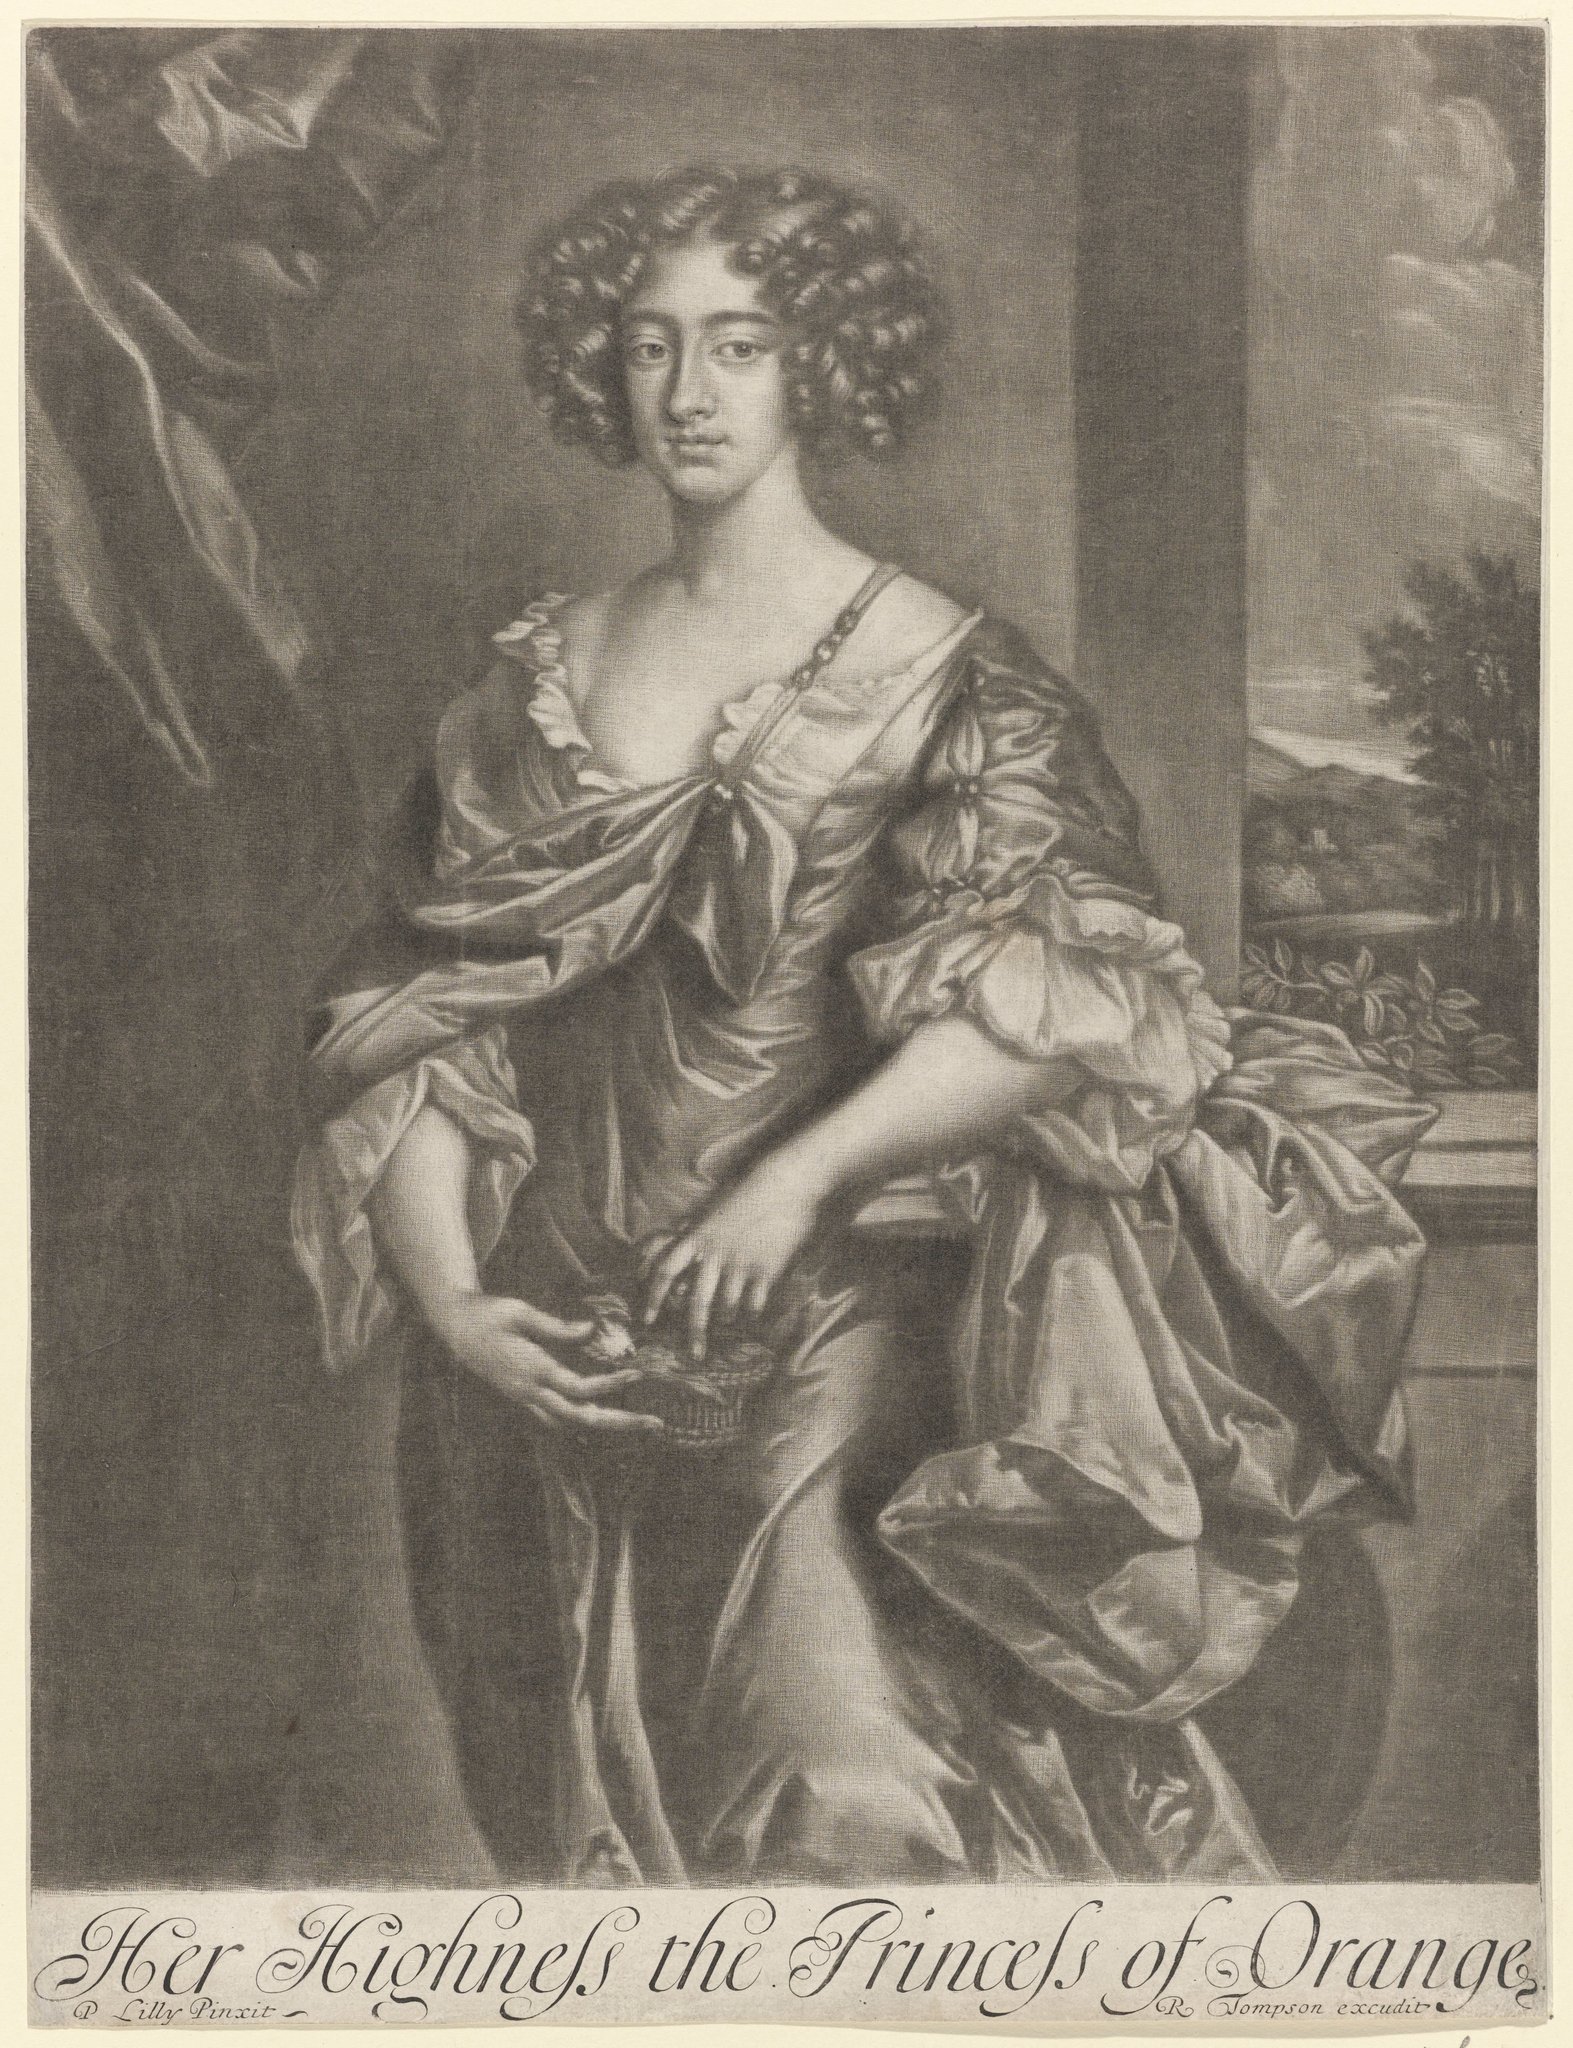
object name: print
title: Portret van Maria II Stuart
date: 1677-1693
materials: paper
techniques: mezzotint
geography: low countries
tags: london, maria ii stuart (koningin van engeland, schotland en ierland)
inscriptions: collector's mark: Lugt 2228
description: Portret van Maria II. In haar handen een bloemenmandje. Op de achtergrond een landschap. In de ondermarge haar titel.